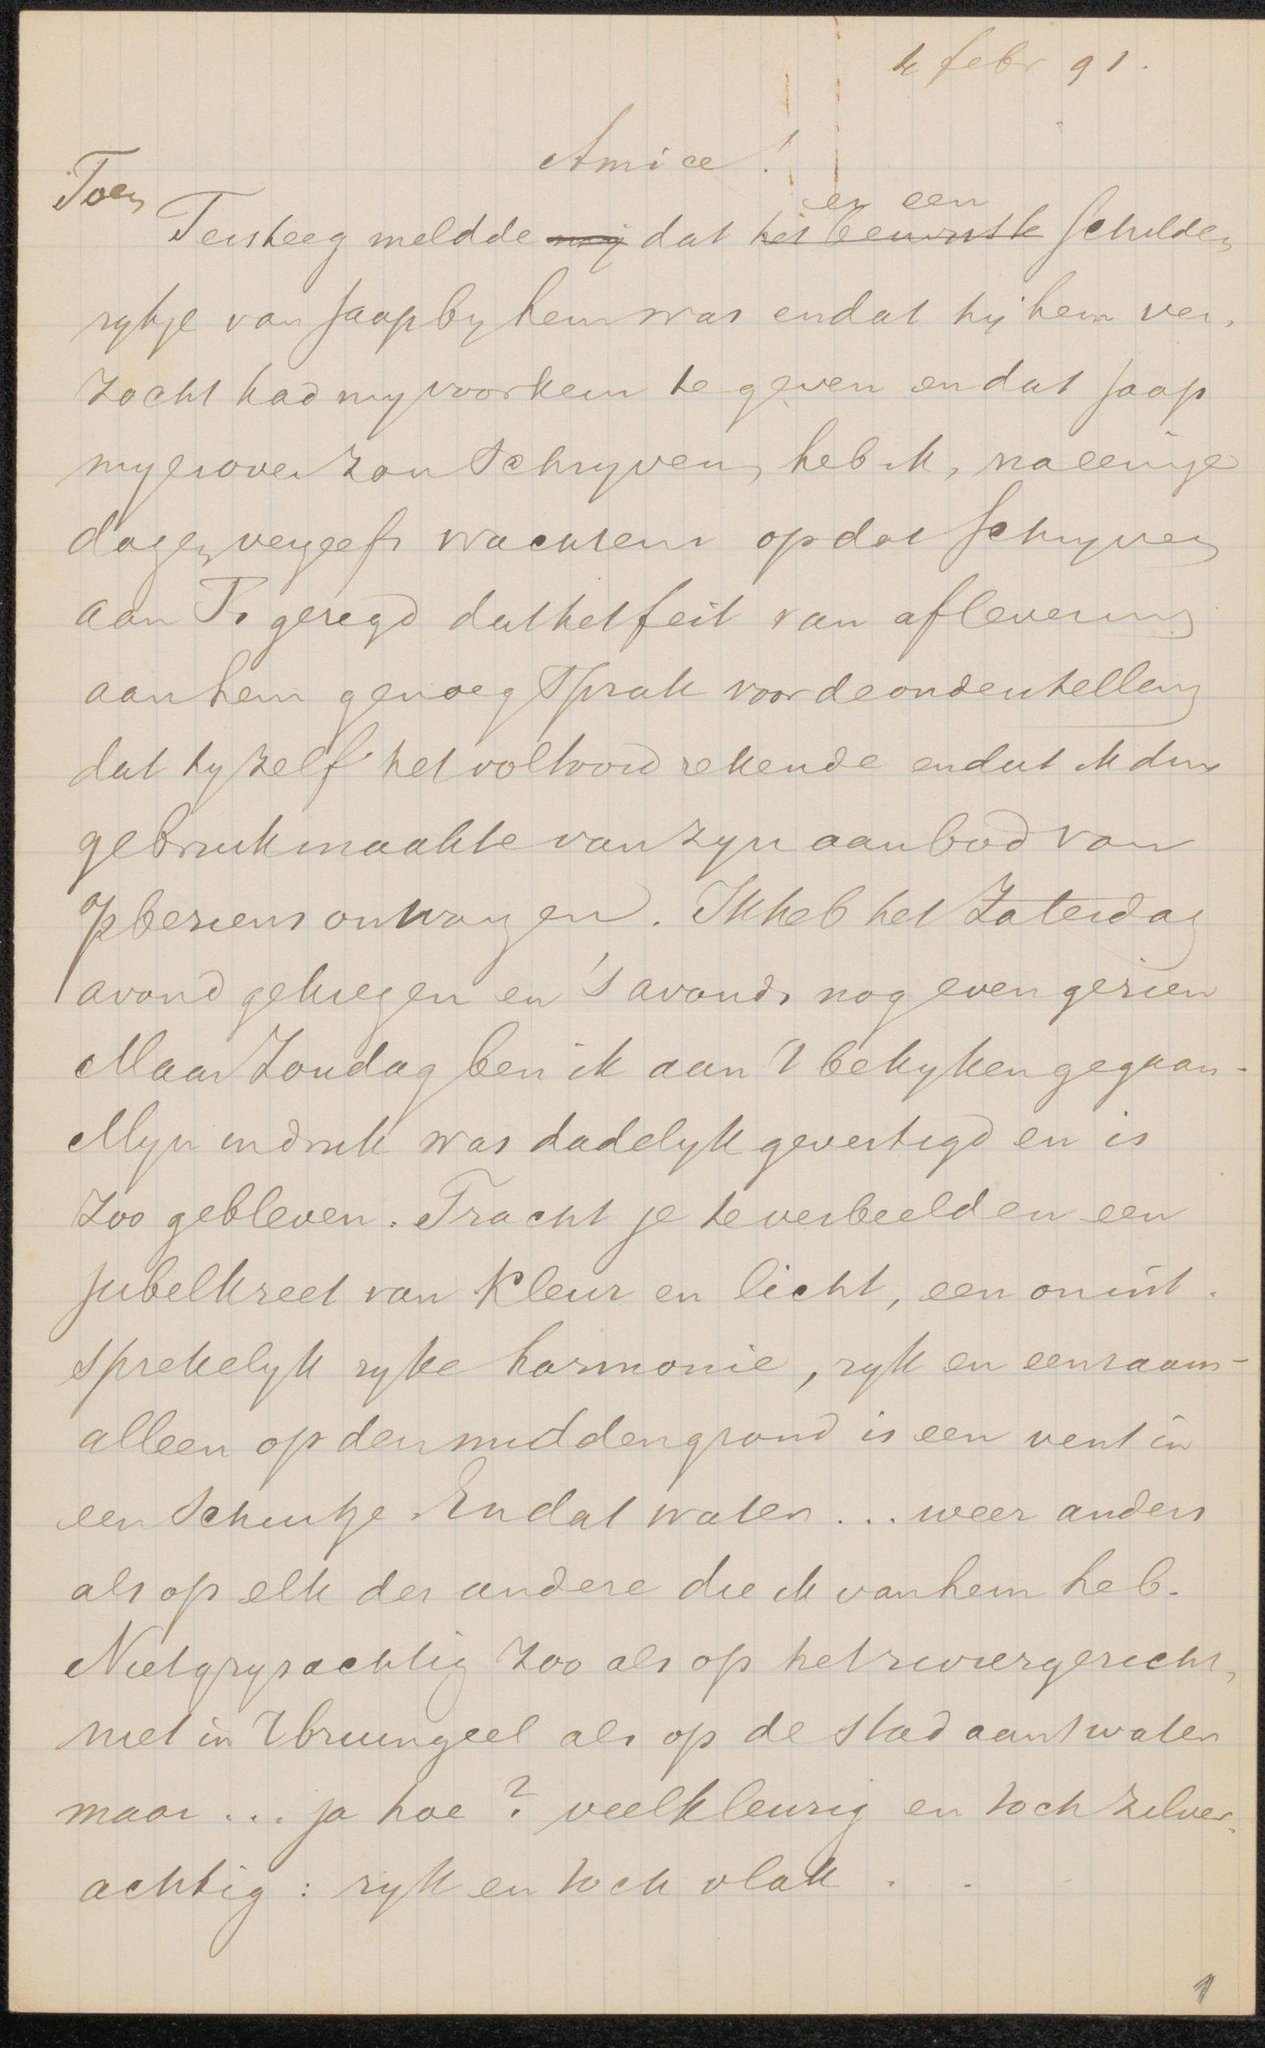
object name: letter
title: Brief aan Jan Veth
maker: martinus cornelis lebret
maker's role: verzamelaar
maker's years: 1833-1894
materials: ink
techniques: pen, writing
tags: rosa bonheur, cornelis springer, painter, daubigny, leiden, alexander hugo bakker korff, david bles, johannes bosboom, amsterdam, designer, jan veth, the hague, hendrik willem mesdag, matthijs maris, camille corot, narcisse virgile diaz de la peña, willem maris, arnhem, anton mauve, jacob maris, utrecht, albert neuhuys (1844-1914), print maker, draughtsman, jean françois millet, david adolph constant artz, isaac israels, edzard koning, frederik hendrik kaemmerer, hermanus gijsbertus tersteeg, paris, sculptor, dordrecht, art trade, art shop, painting (including book-illumination, miniature-painting), exhibition ~ art, printed matter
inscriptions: collector's mark: ‘RPK’